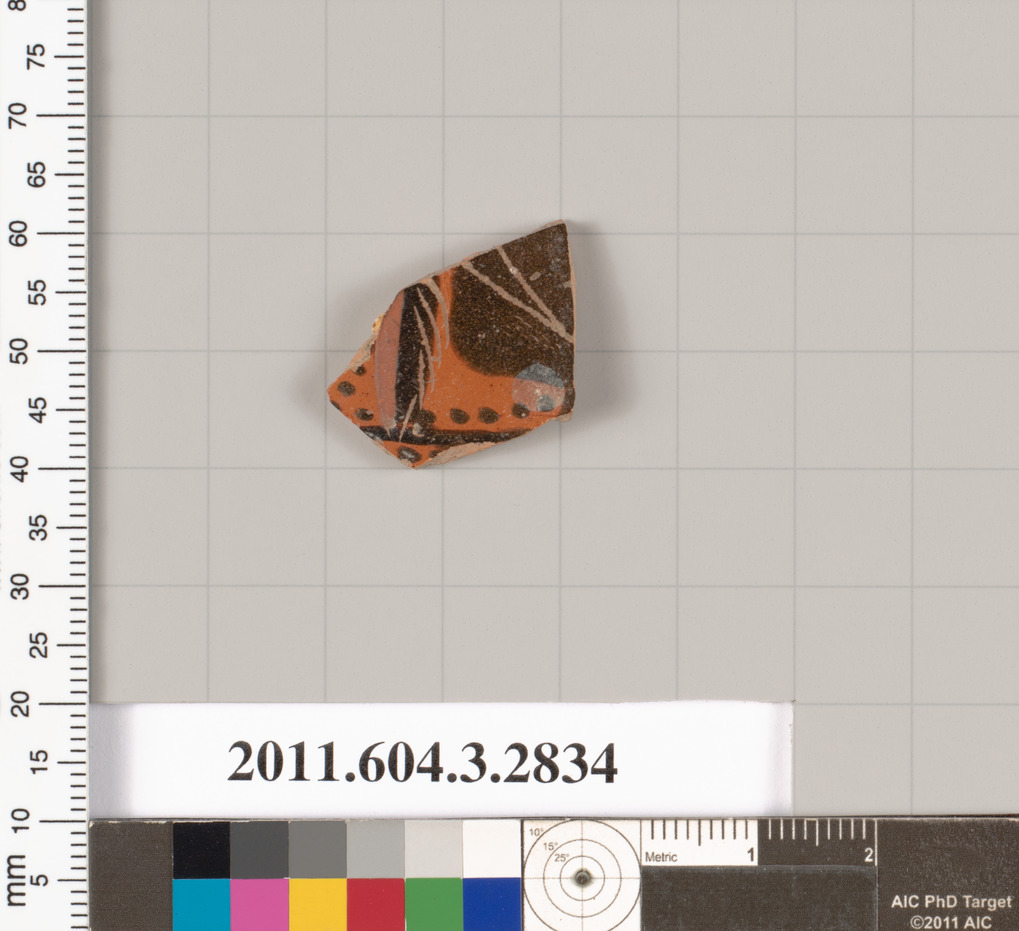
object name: undetermined closed shape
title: Terracotta fragment of a closed shape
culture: greek, attic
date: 510-500 BCE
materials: terracotta